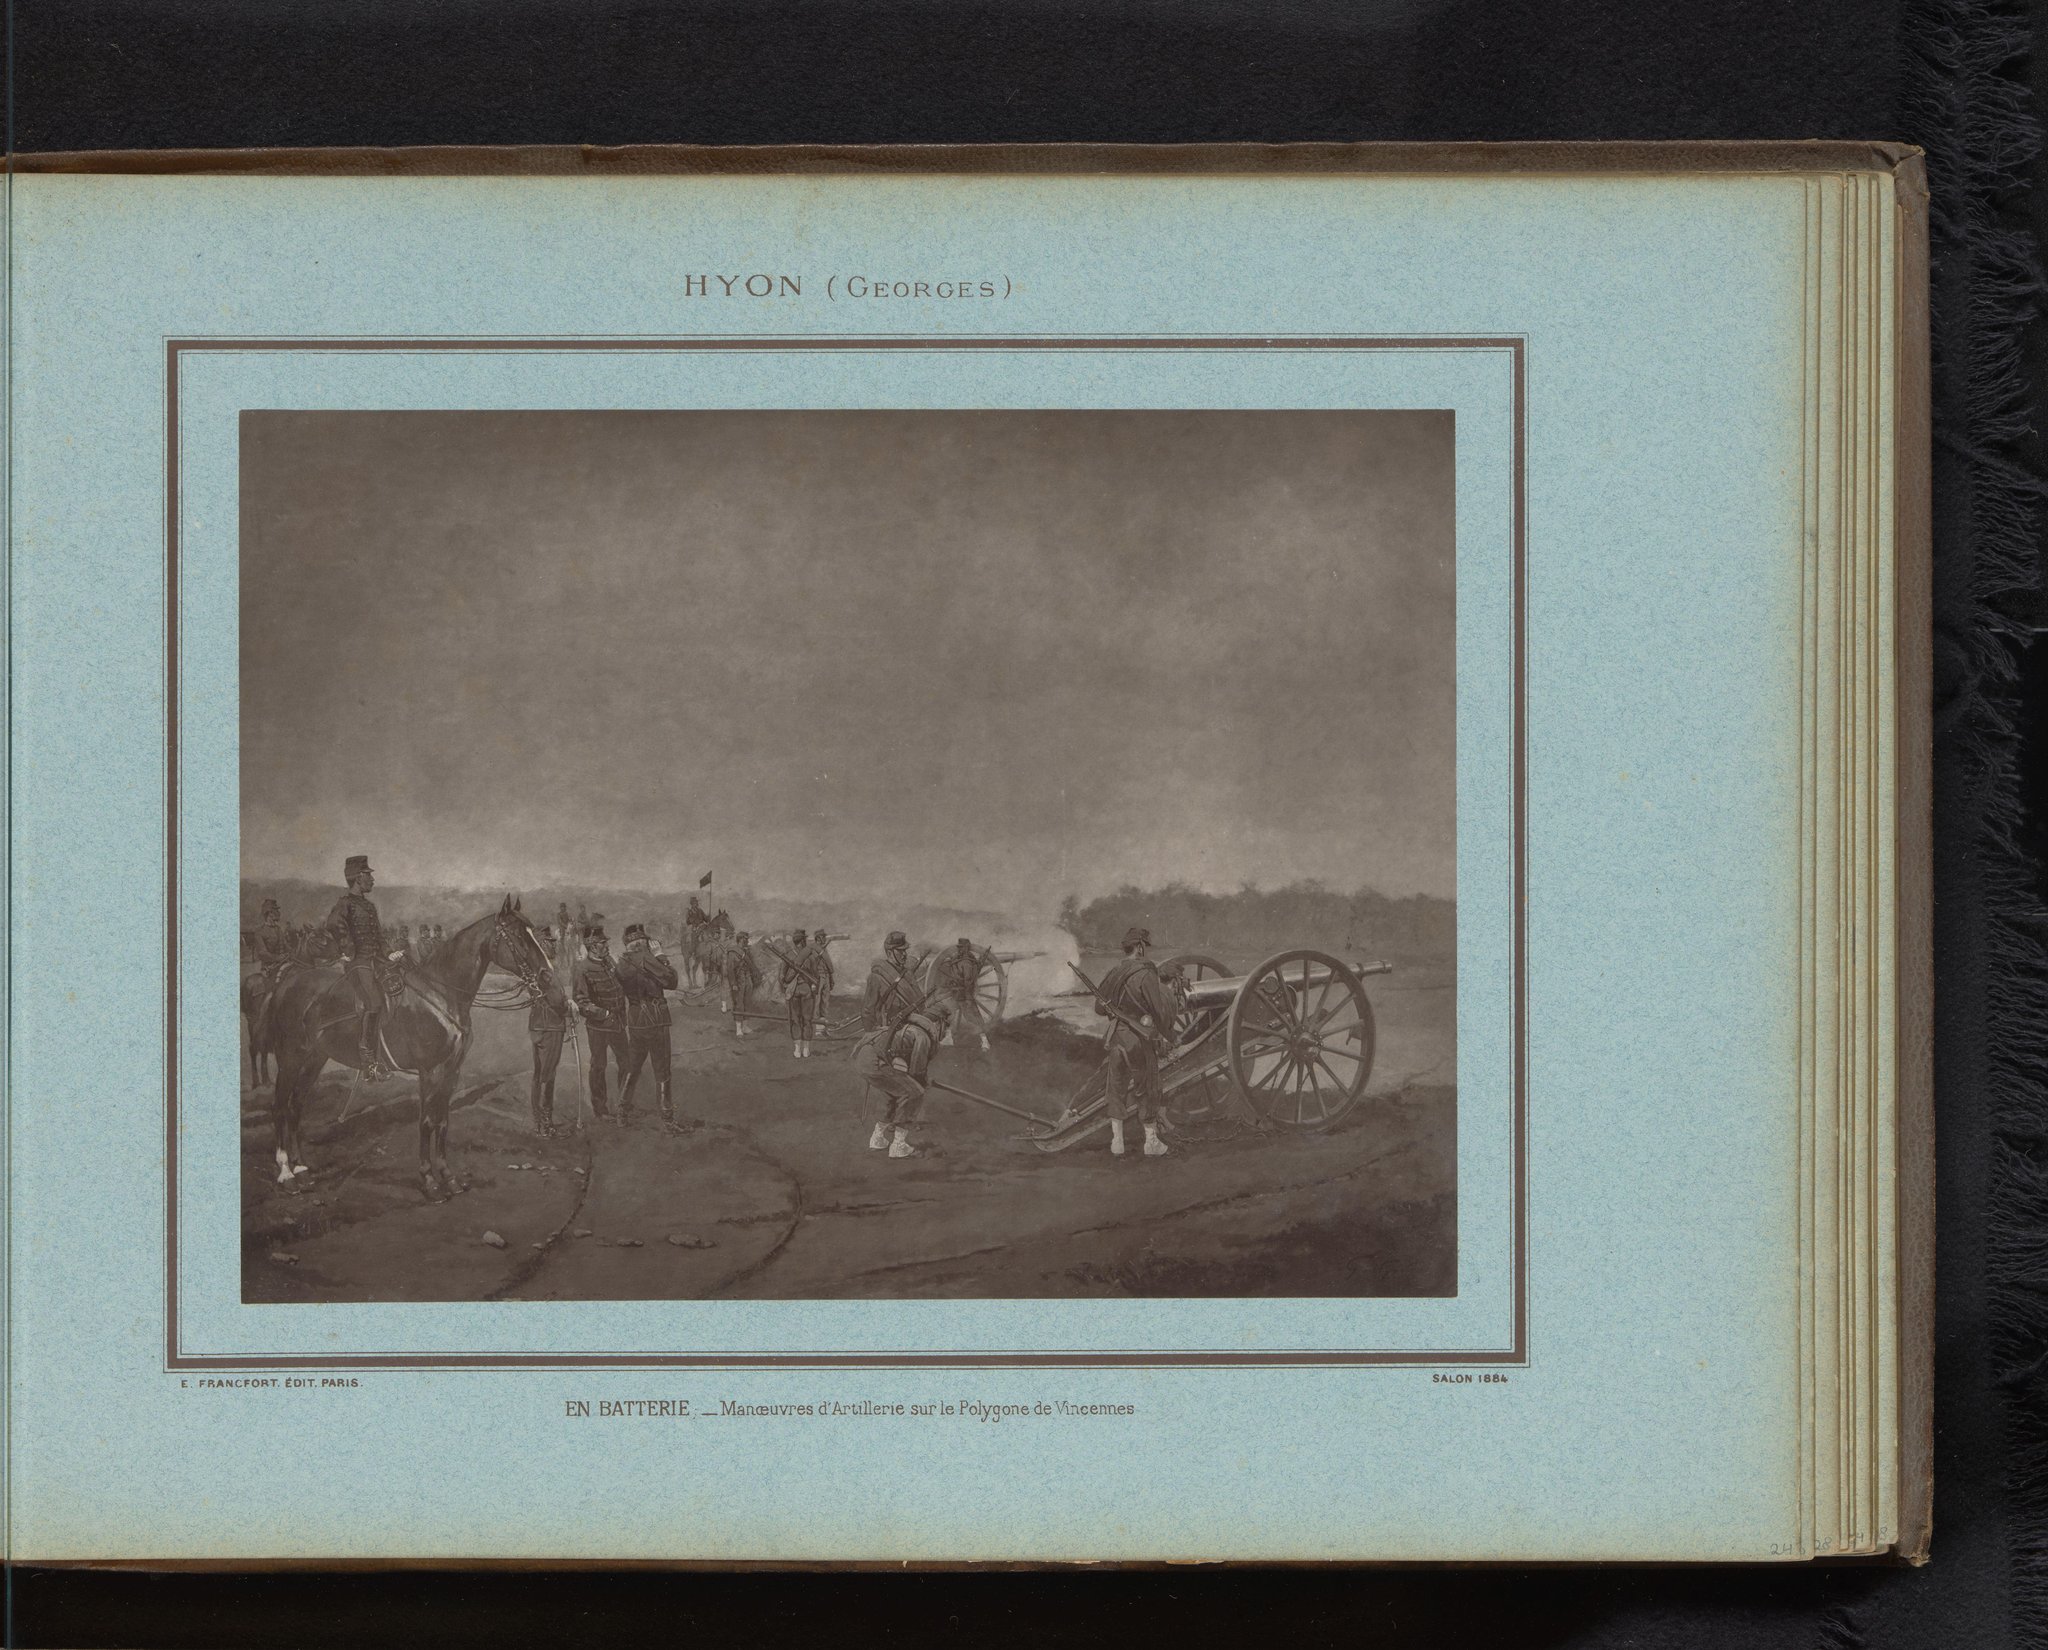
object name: reproduction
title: En Batterie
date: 1884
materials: paper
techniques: woodburytype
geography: paris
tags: battle (+ artillery)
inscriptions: inscription: ‘SALON 1884.’, name: ‘HYON (Georges)’, inscription: ‘Manœuvres d'Artillerie sur le Polygone de Vincennes’